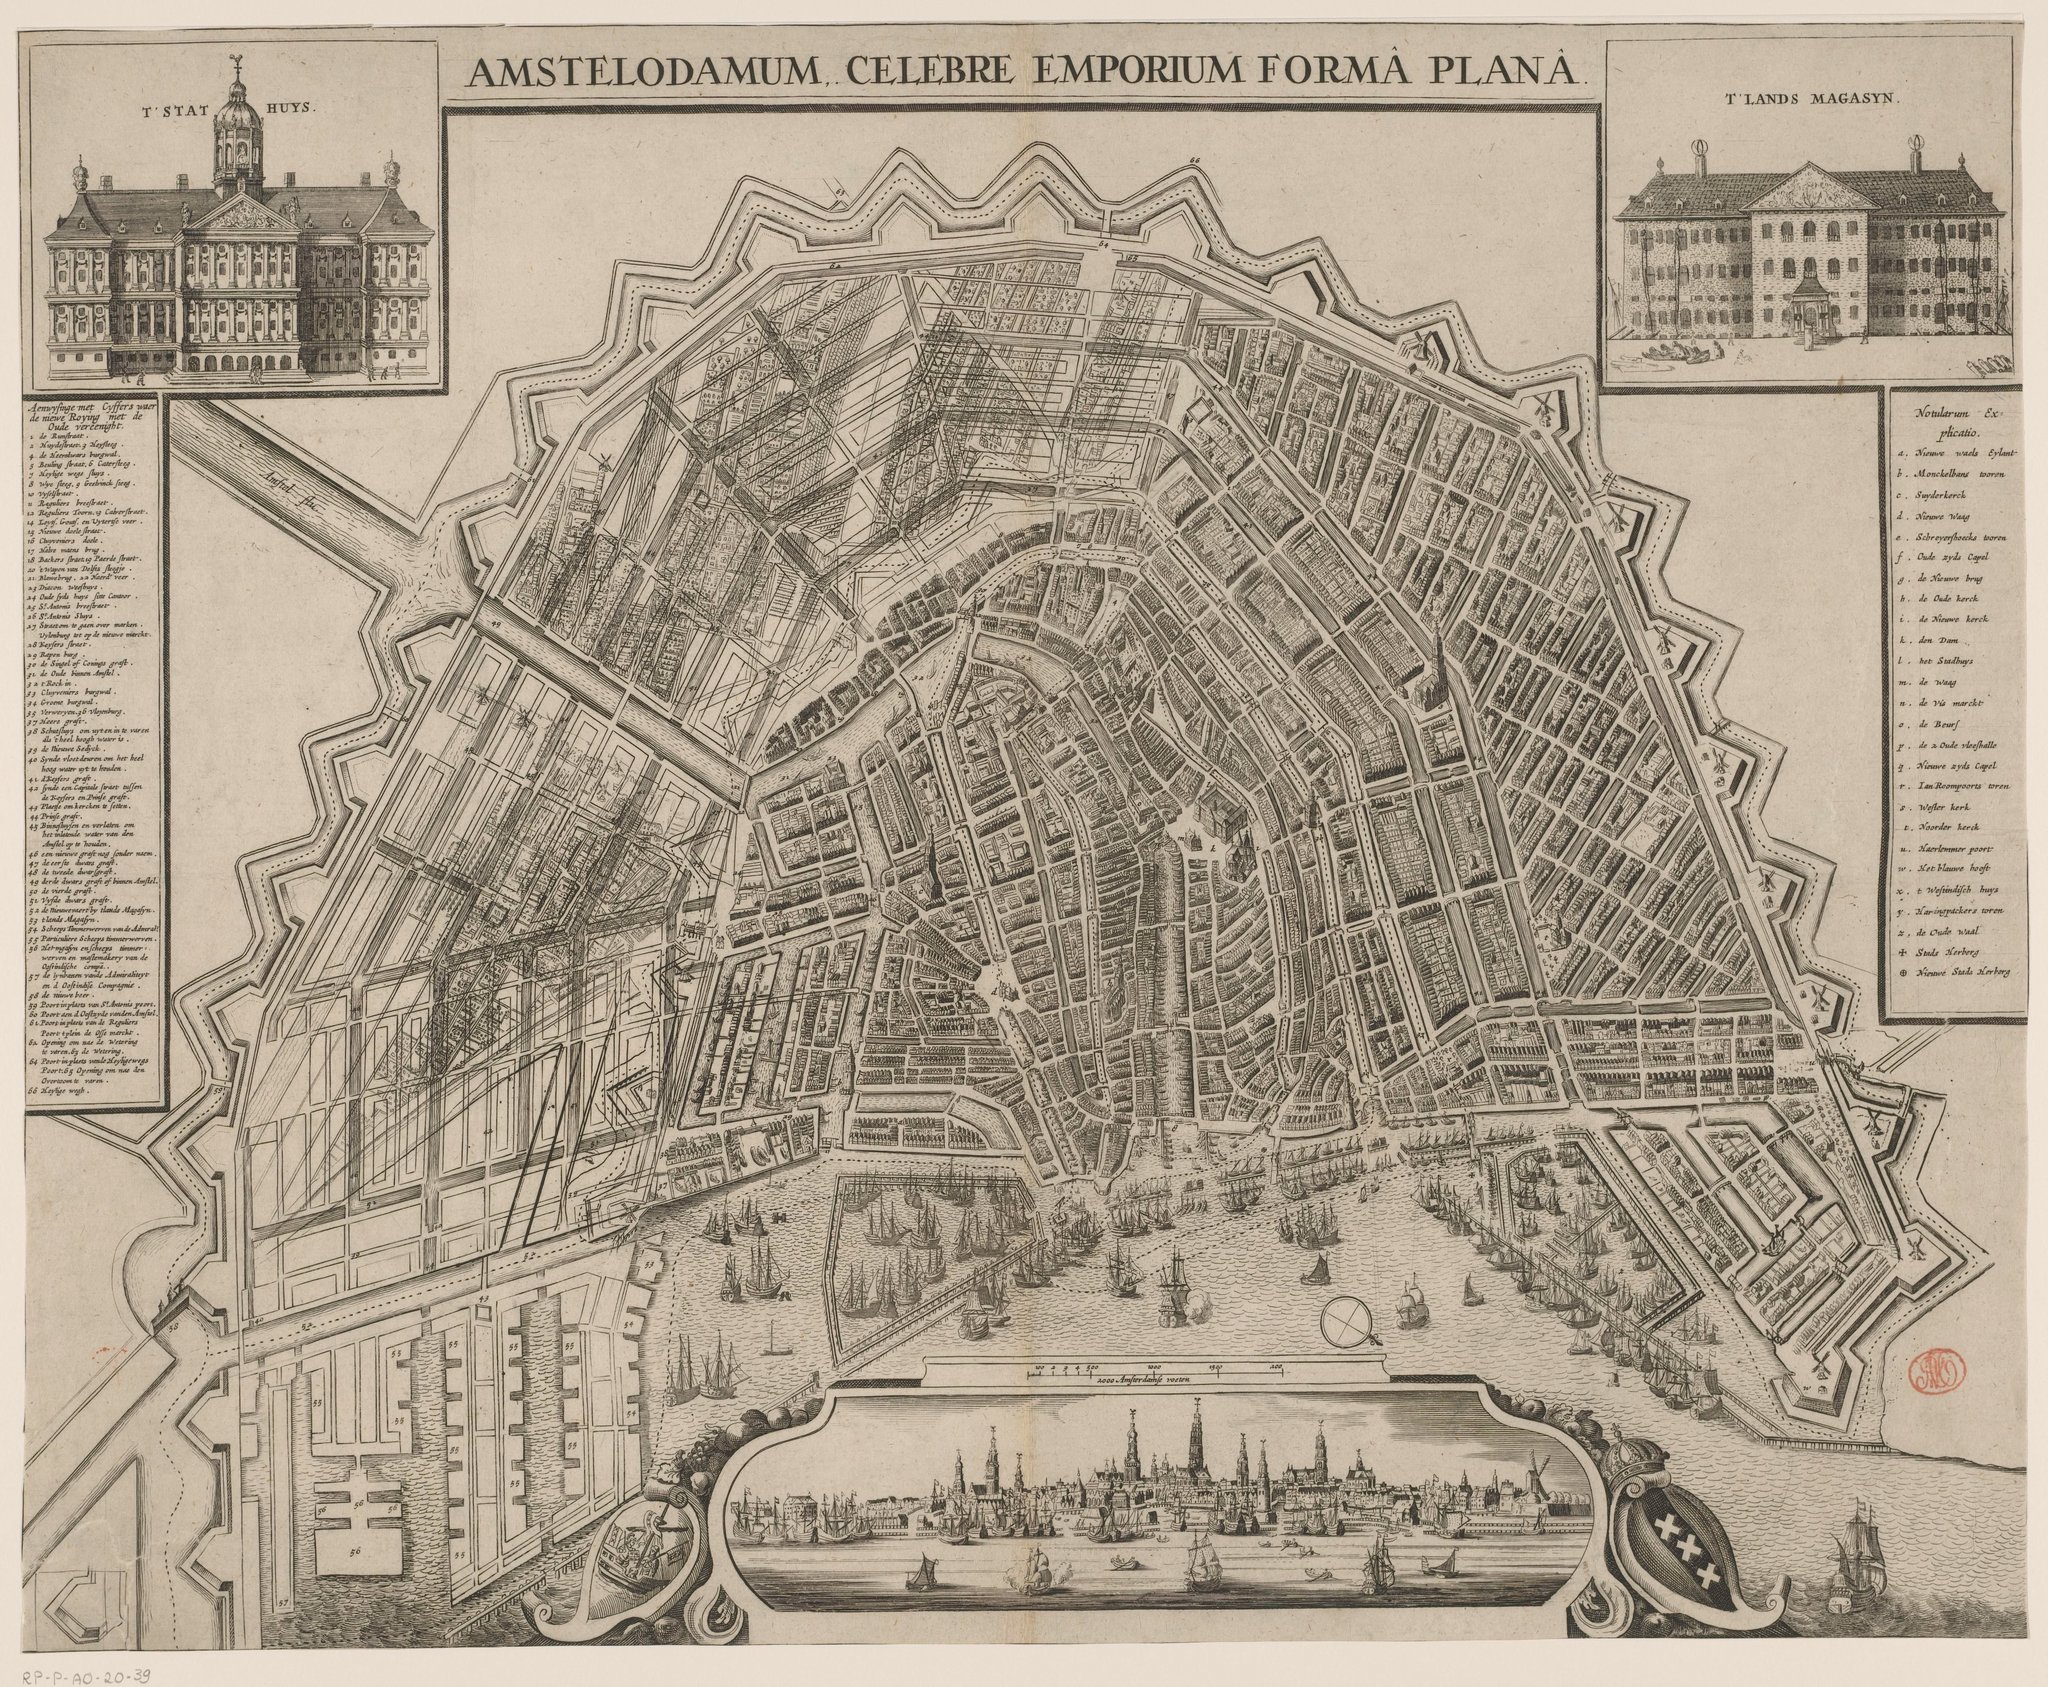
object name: area plan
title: Plattegrond van Amsterdam met ontwerp voor de Vierde Uitleg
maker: Anonymous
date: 1662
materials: paper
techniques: engraving, etching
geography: amsterdam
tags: large-scale structure for storage, e.g.: warehouse, depot, silo, coat of arms (as symbol of the state, etc.) (+ city; municipal), seal (as symbol of the state, etc.) (+ city; municipal), townhall, maps of cities, prospect of city, town panorama, silhouette of city, royal palace of amsterdam, amsterdam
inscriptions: collector's mark: Lugt 195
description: Plattegrond van Amsterdam met het ontwerp van Daniel Stalpaert voor de Vierde Uitleg (uitbreiding) van de stad, in vogelvluchtperspectief. De nieuwe perceellering is over de oude situatie gegraveerd, waardoor de kaart lastig te lezen is. Linksboven een gezicht op het nieuwe Stadhuis op de Dam, daaronder de legenda 1-66. Boven in het midden de titel. Rechtsboven een gezicht op 's Lands Zeemagazijn (Admiraliteitsmagazijn), daaronder de legenda a-z. Onder in het midden een gezicht op de stad, geflankeerd door het stadszegel (links) en het wapen van de stad (rechts). Daarboven een schaalstok: 200 Amsterdamse voeten. Oriëntatie: zuidzuidwest boven.